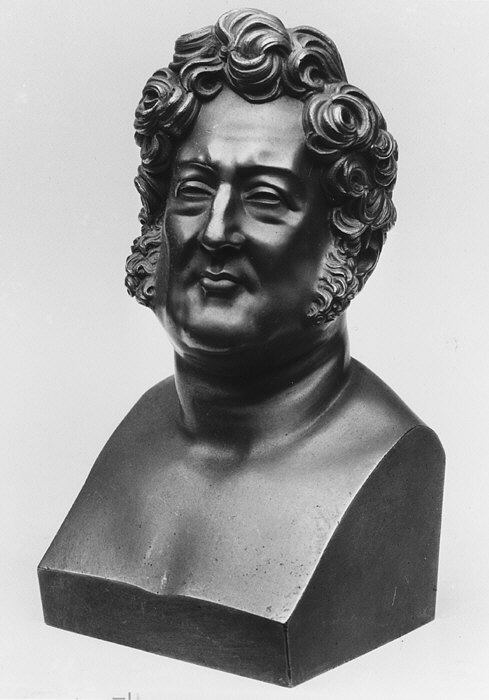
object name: bust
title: Louis Philippe of France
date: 1830-1848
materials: gilt bronze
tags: men,portraits